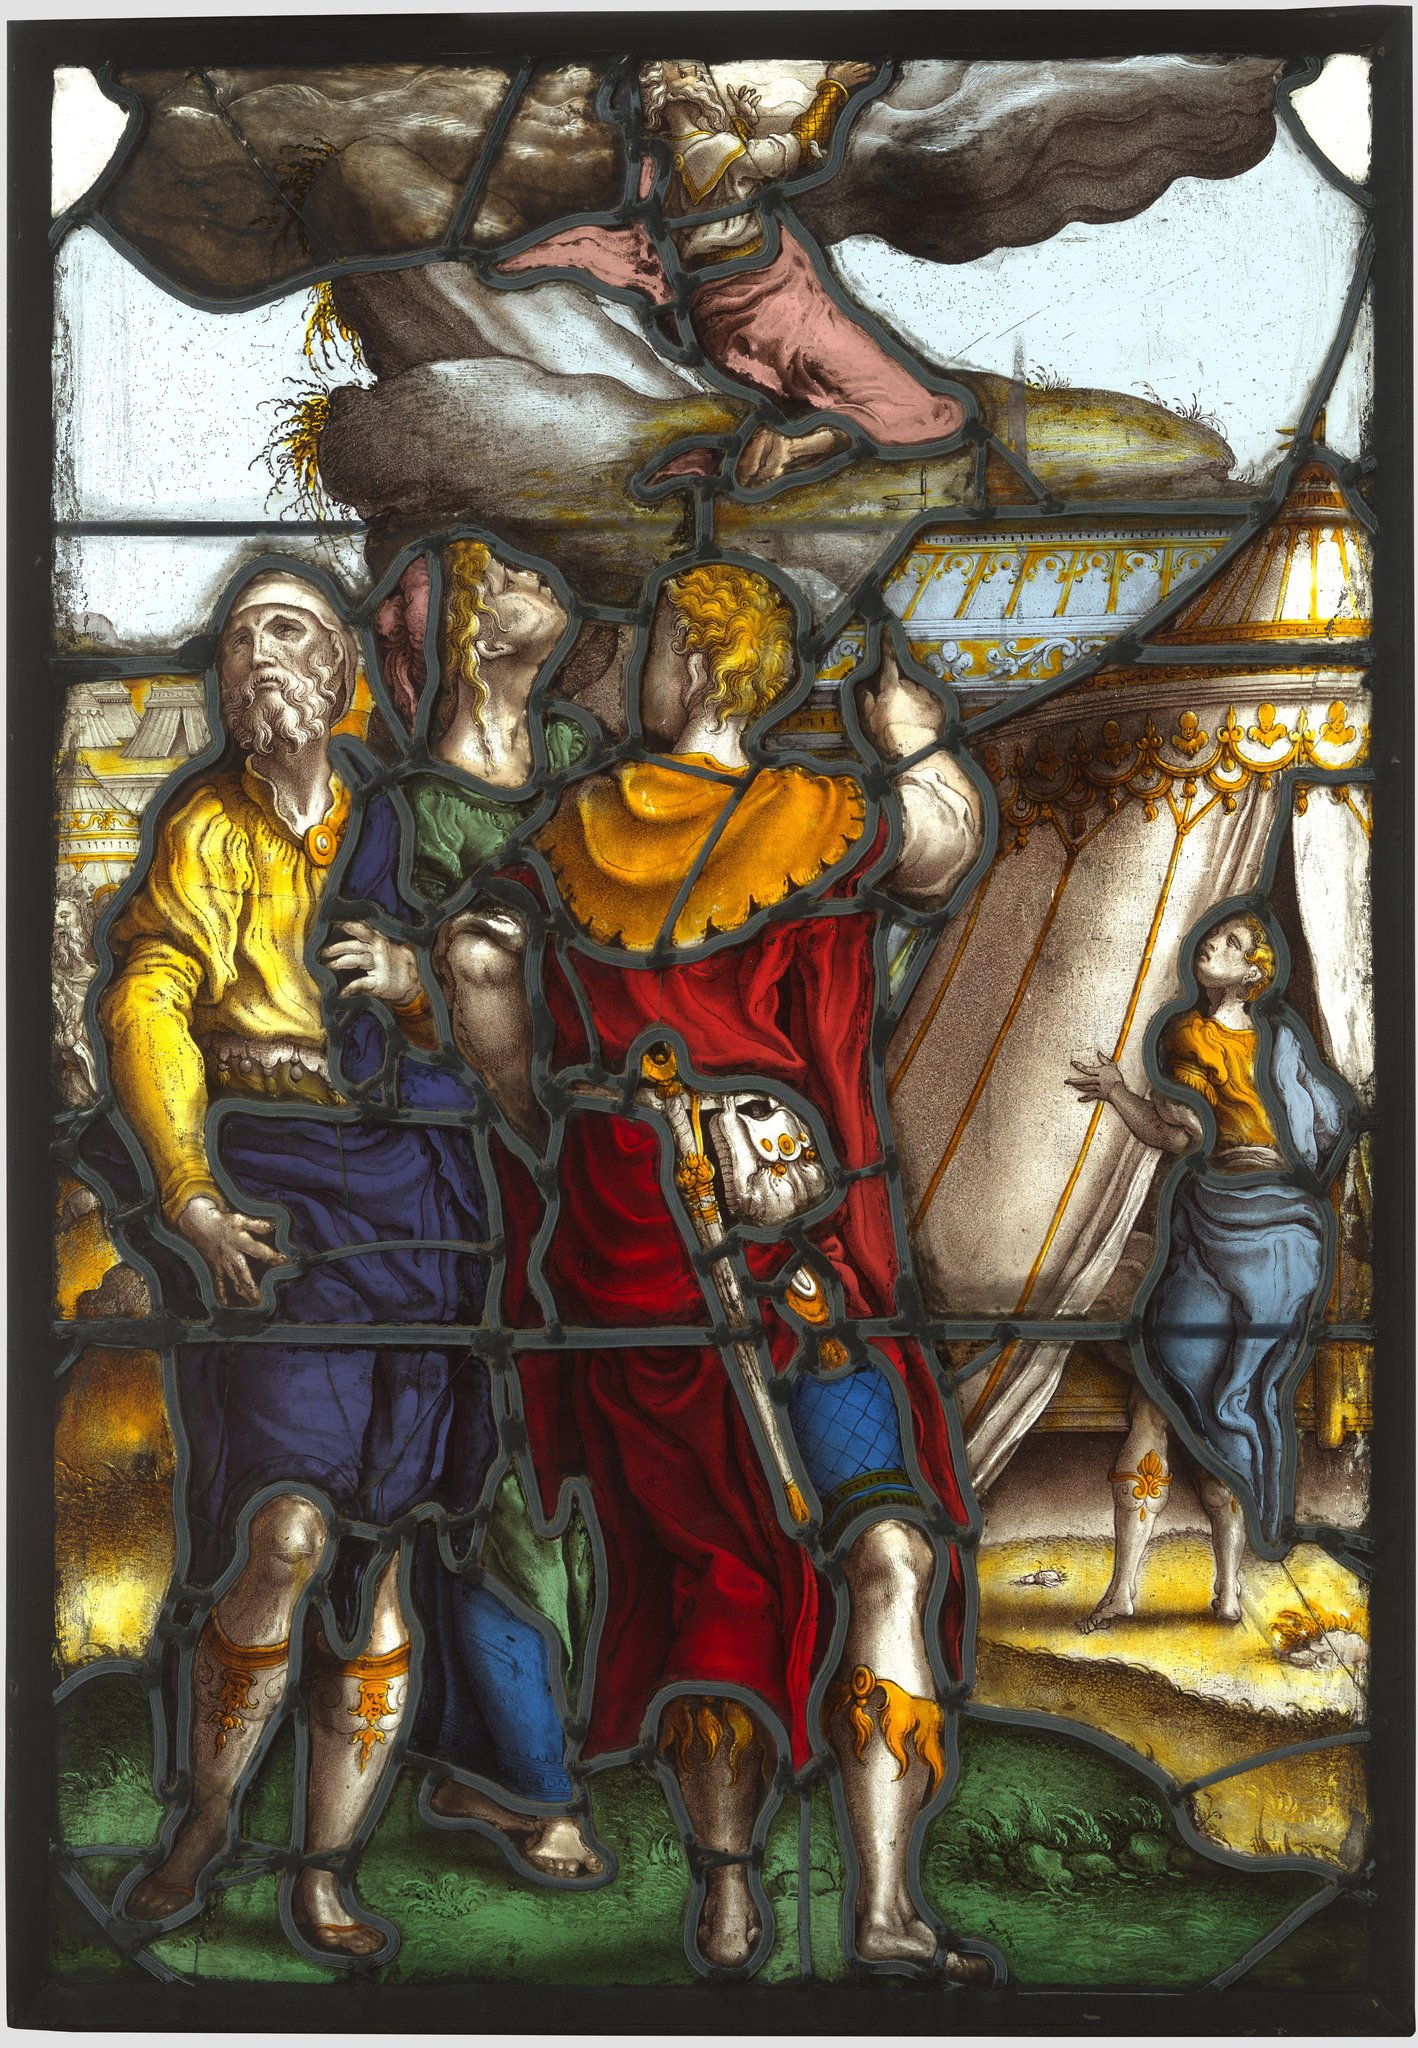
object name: light window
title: Ruit met voorstelling van Mozes op de berg Sinaï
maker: pieter coecke van aelst (i)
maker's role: draughtsman, print maker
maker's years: 1502-1550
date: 1525-1550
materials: glass, lead, pigment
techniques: leading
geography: netherlands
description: Moses on Mount Sinai. Stained glass. Netherlands, c. 1525 - 1550, circle of Pieter Coecke van Aelst.